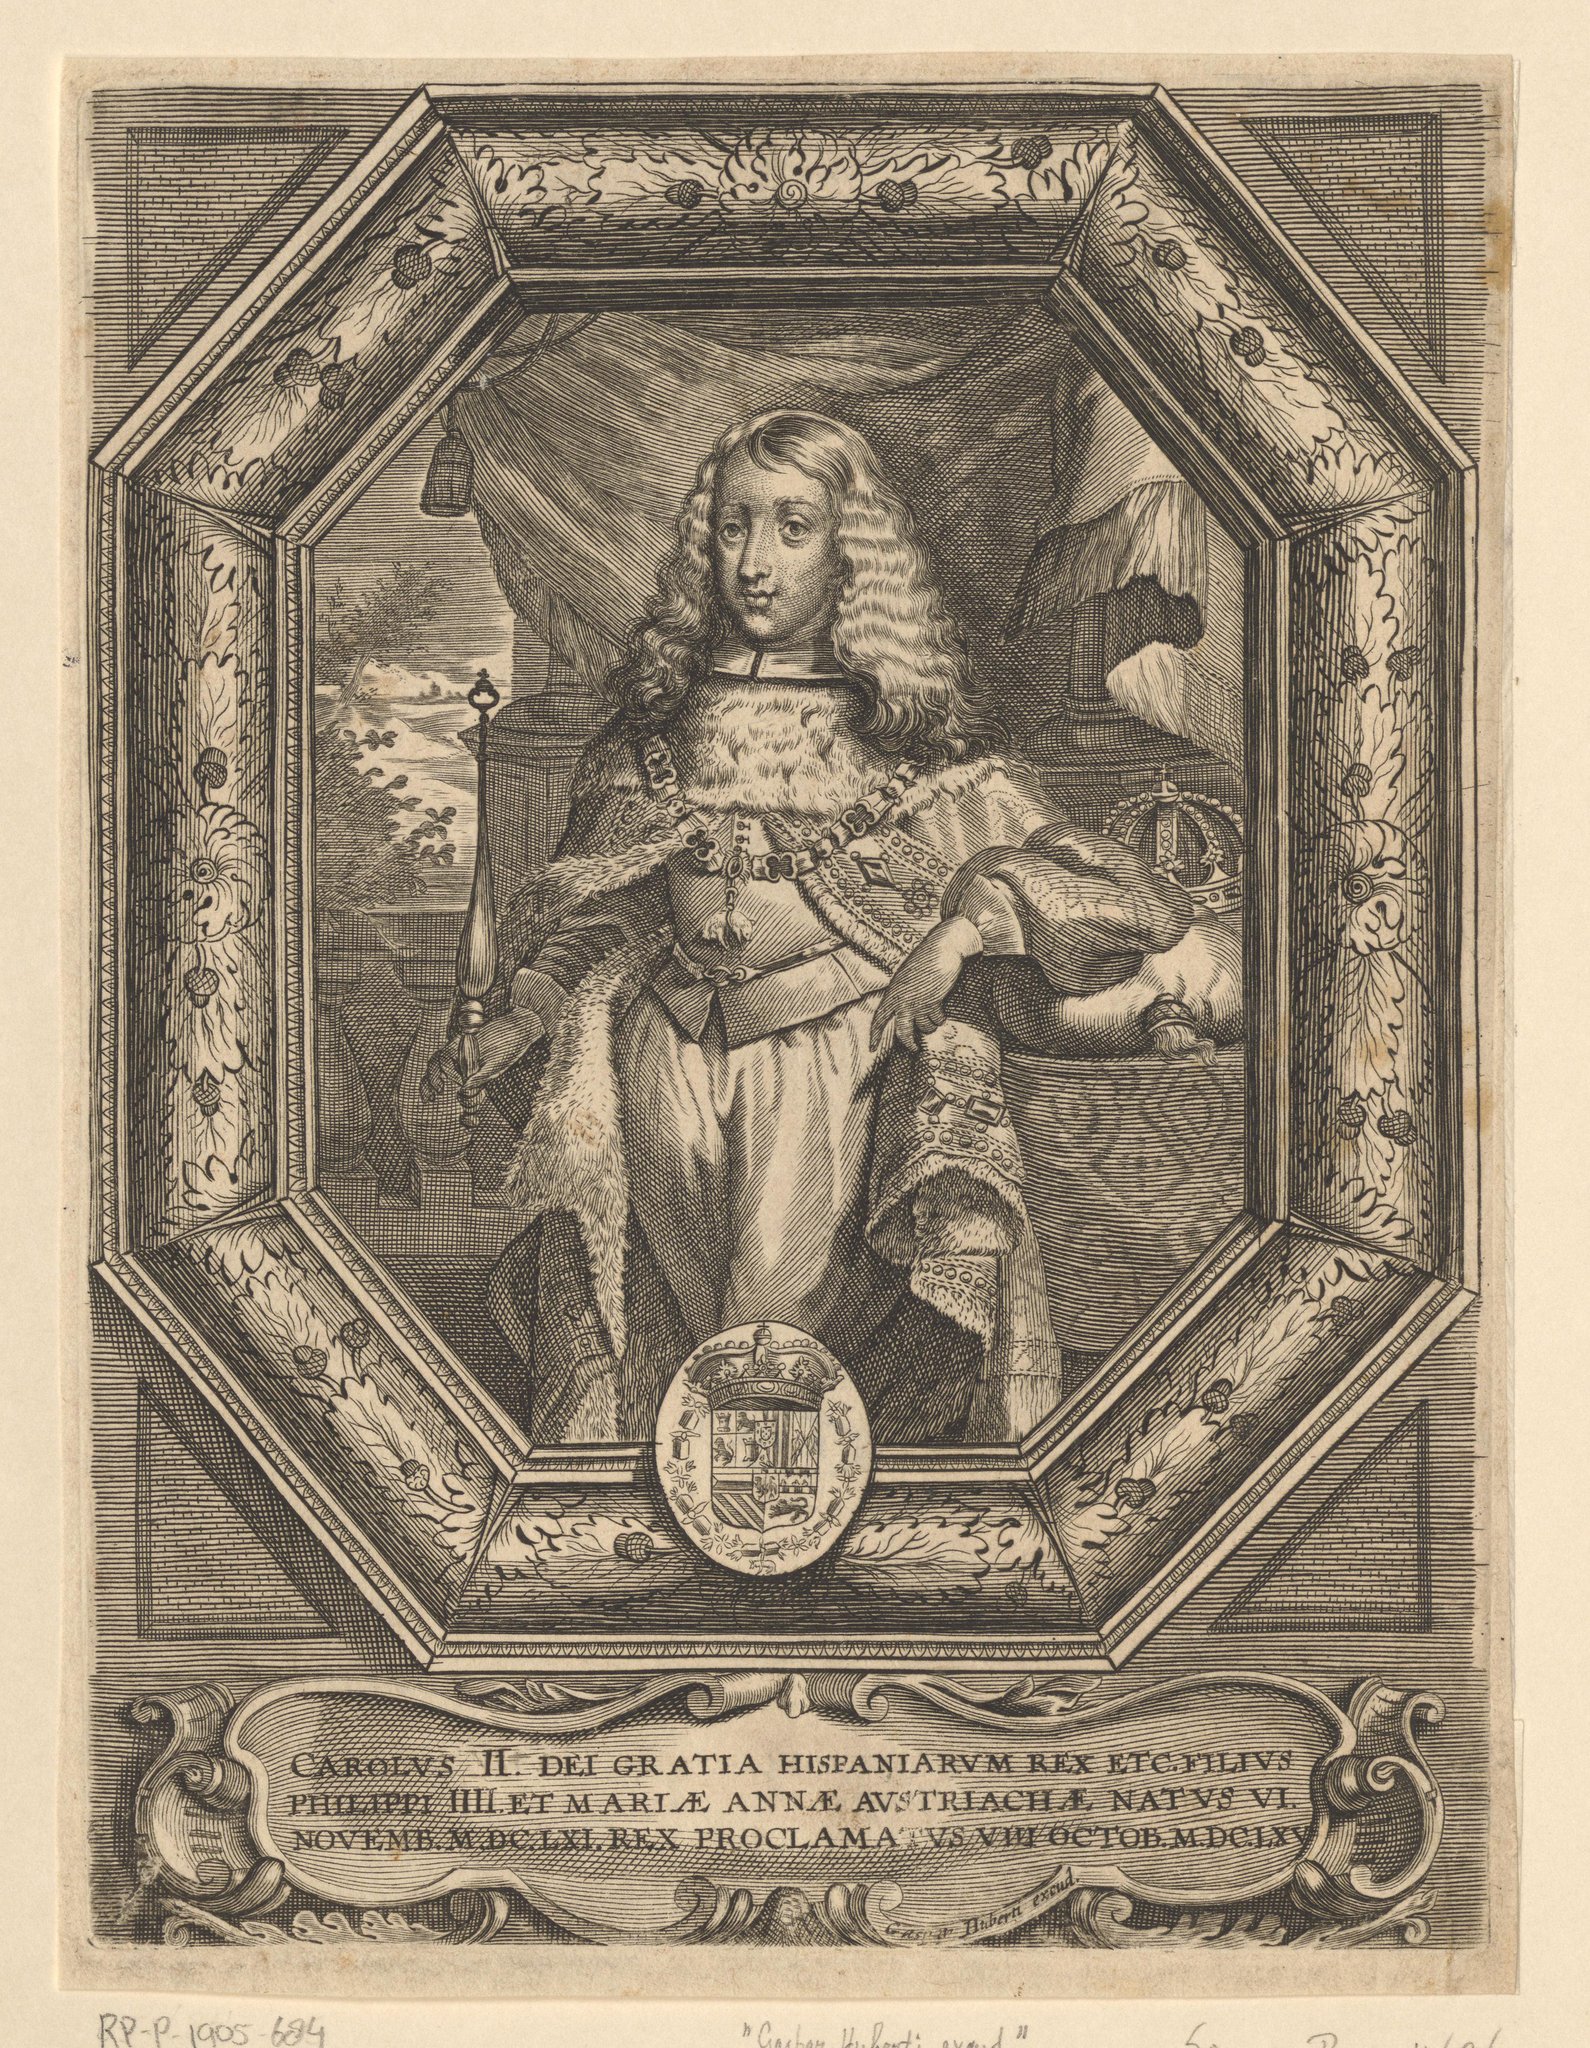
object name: print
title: Portret van Karel II van Spanje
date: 1665-1681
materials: paper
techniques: engraving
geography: antwerp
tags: karel ii (koning van spanje), crown (symbol of sovereignty), sceptre, staff (symbol of sovereignty), historical persons, knighthood order of the golden fleece, armorial bearing, heraldry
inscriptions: collector's mark: Lugt 2228